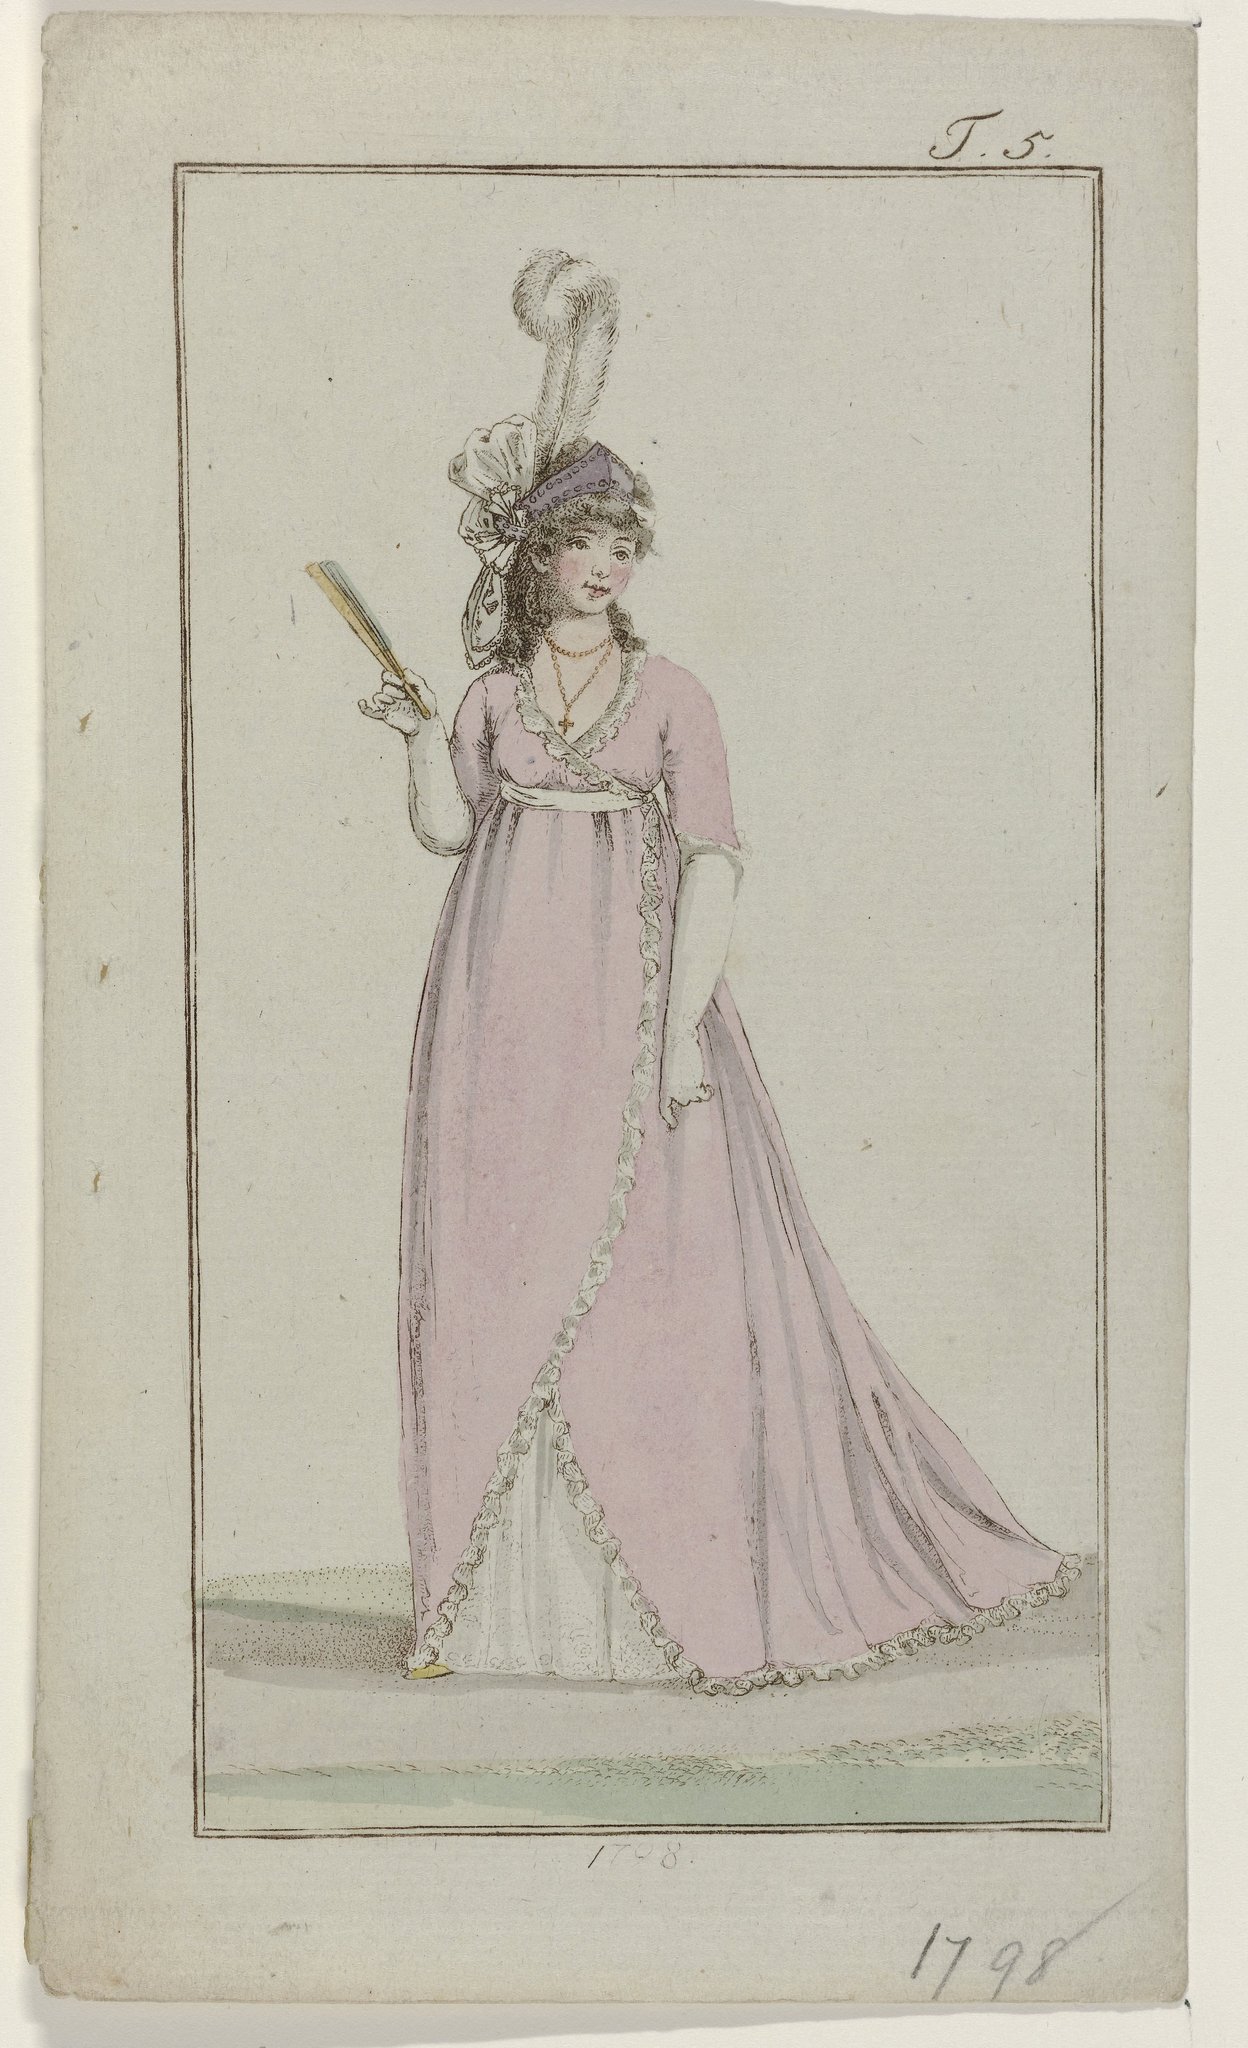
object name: fashion print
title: Journal des Luxus und der Moden, 1798, T 5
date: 1798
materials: paper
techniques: etching, hand coloring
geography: weimar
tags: diadem, tiara (+ women's clothes), gloves, mittens (long gloves) (+ women's clothes), head-gear (+ women's clothes), fashion plates, skirt (+ women's clothes), dress, gown (+ women's clothes), fan (+ women's clothes), necklace (+ women's clothes), belt, girdle, waistband (+ women's clothes)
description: Staande vrouw gekleed in een japon met overslag, driekwart mouwen en sleepje, afgezet met een gerimpelde strook stof. In het haar een diadeem versierd met een struisveer en doek. Verdere accessoires: collier bestaande uit twee snoeren met kruis, ceintuur, lange handschoenen, waaier. Prent uit het modetijdschrift Journal des Luxus und der Moden, uitgegeven door Friedrich Justin Bertuch en Georg Melchior Kraus, Weimar, 1786-1826.